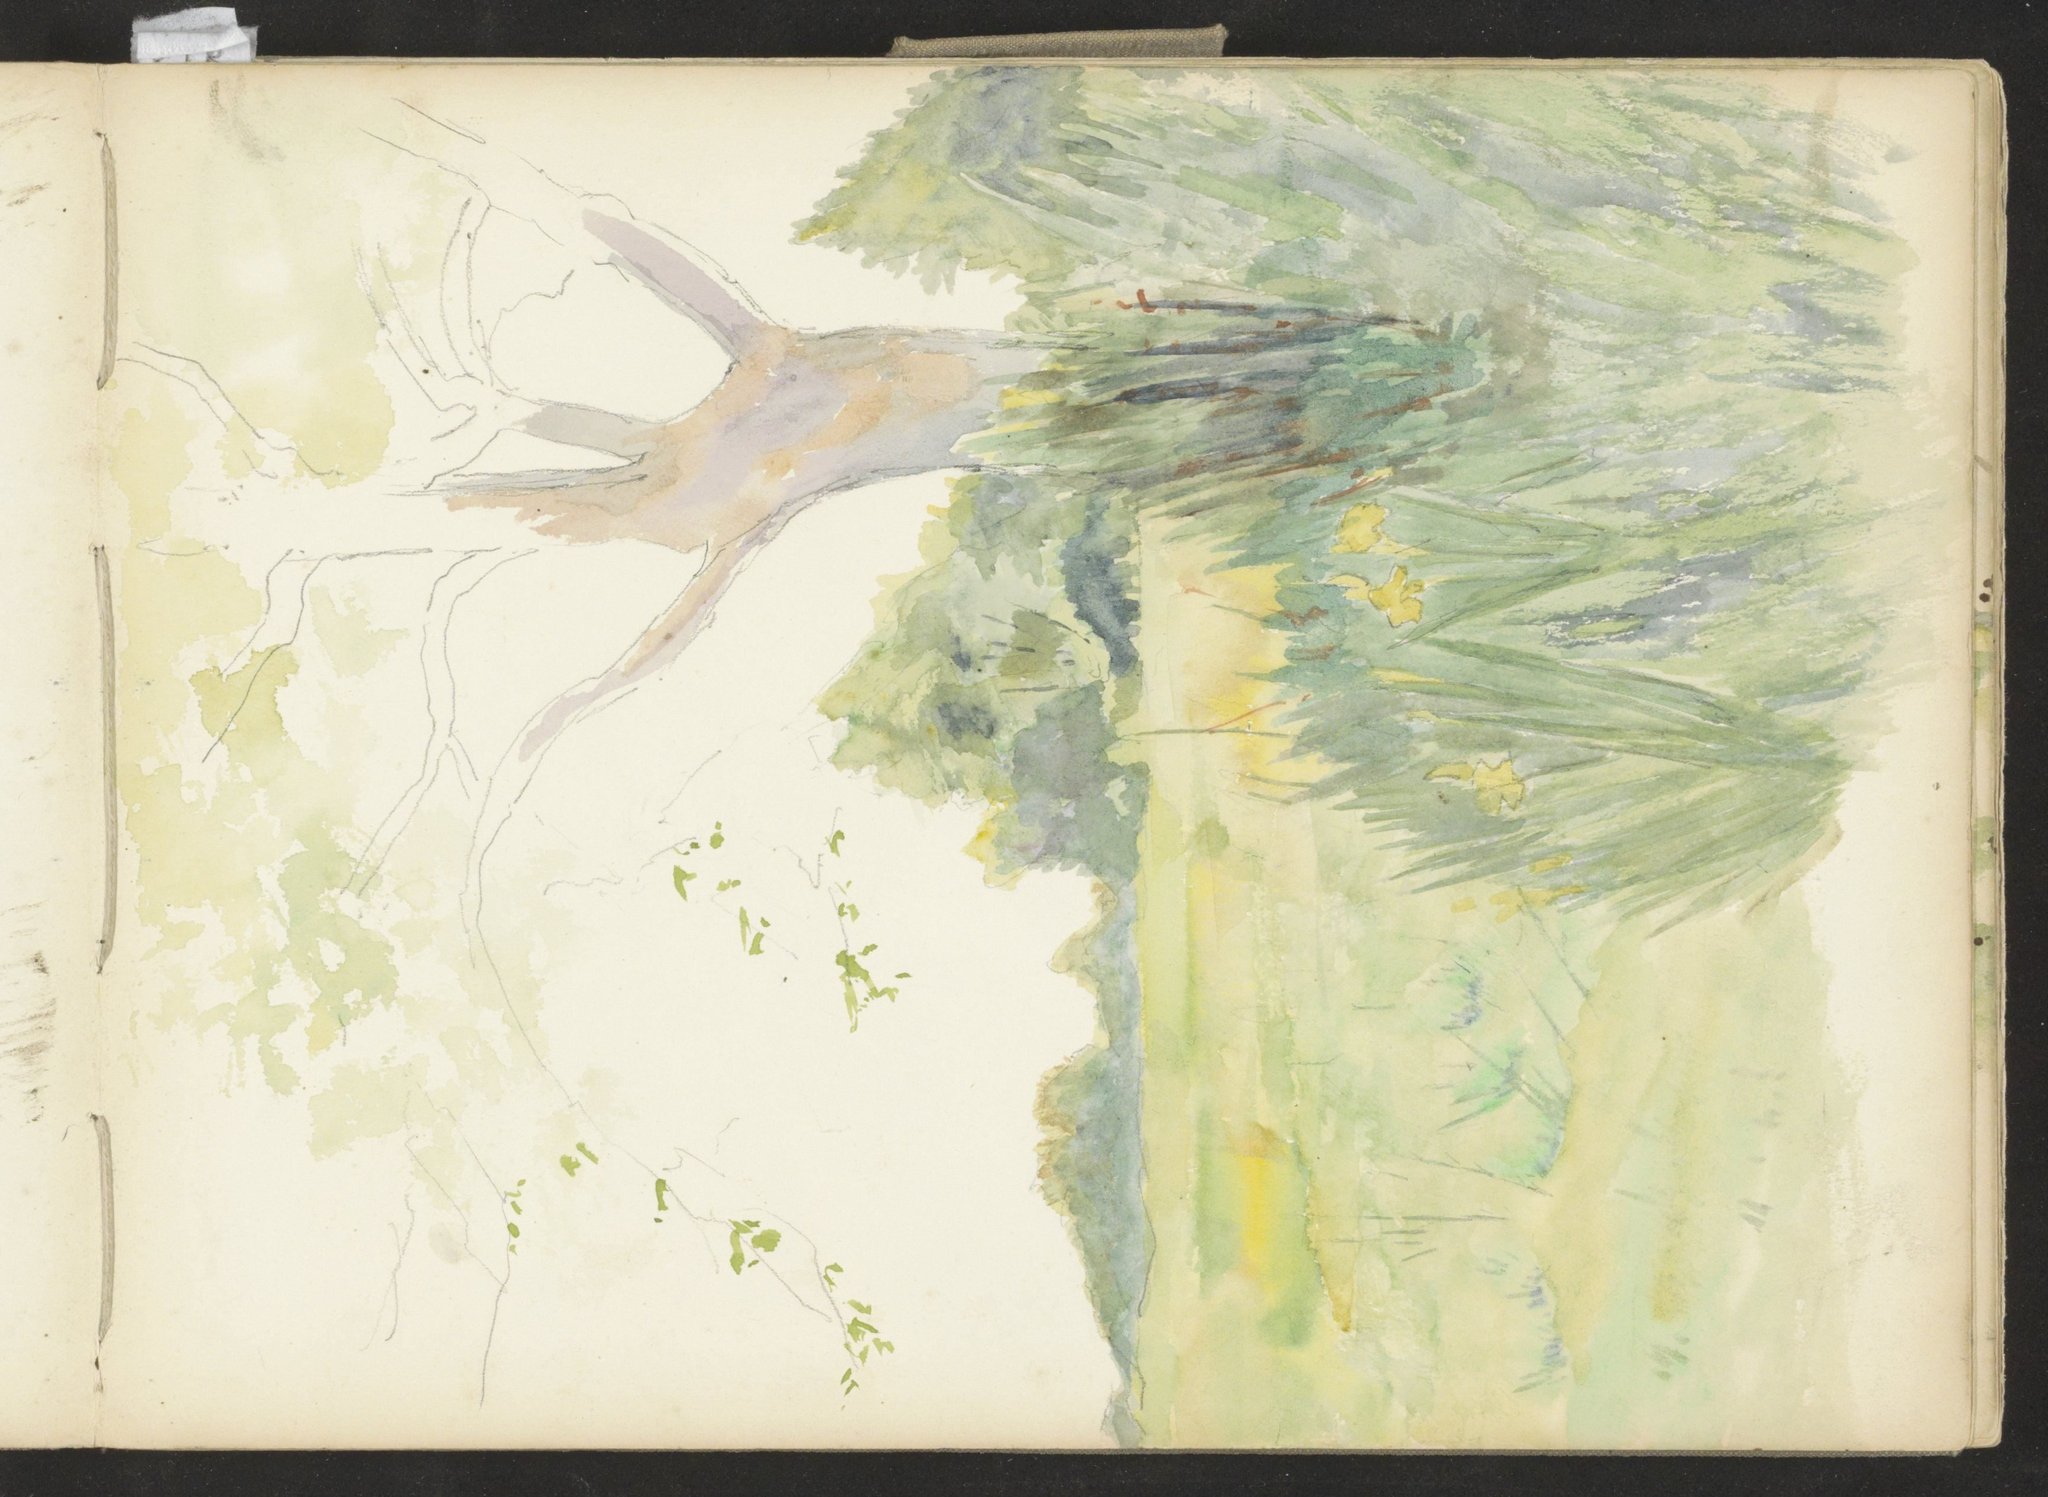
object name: sketchbook leaf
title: Weide met bomen, struiken en narcissen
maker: jonkheer johannes ludovicus paulus bosch van drakestein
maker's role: draughtsman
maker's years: 1865-1929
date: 1913-1916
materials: paper, pencil, watercolor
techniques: brush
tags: meadow, pasture, flowers: narcissus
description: Blad 2 recto uit een schetsboek met 47 bladen.